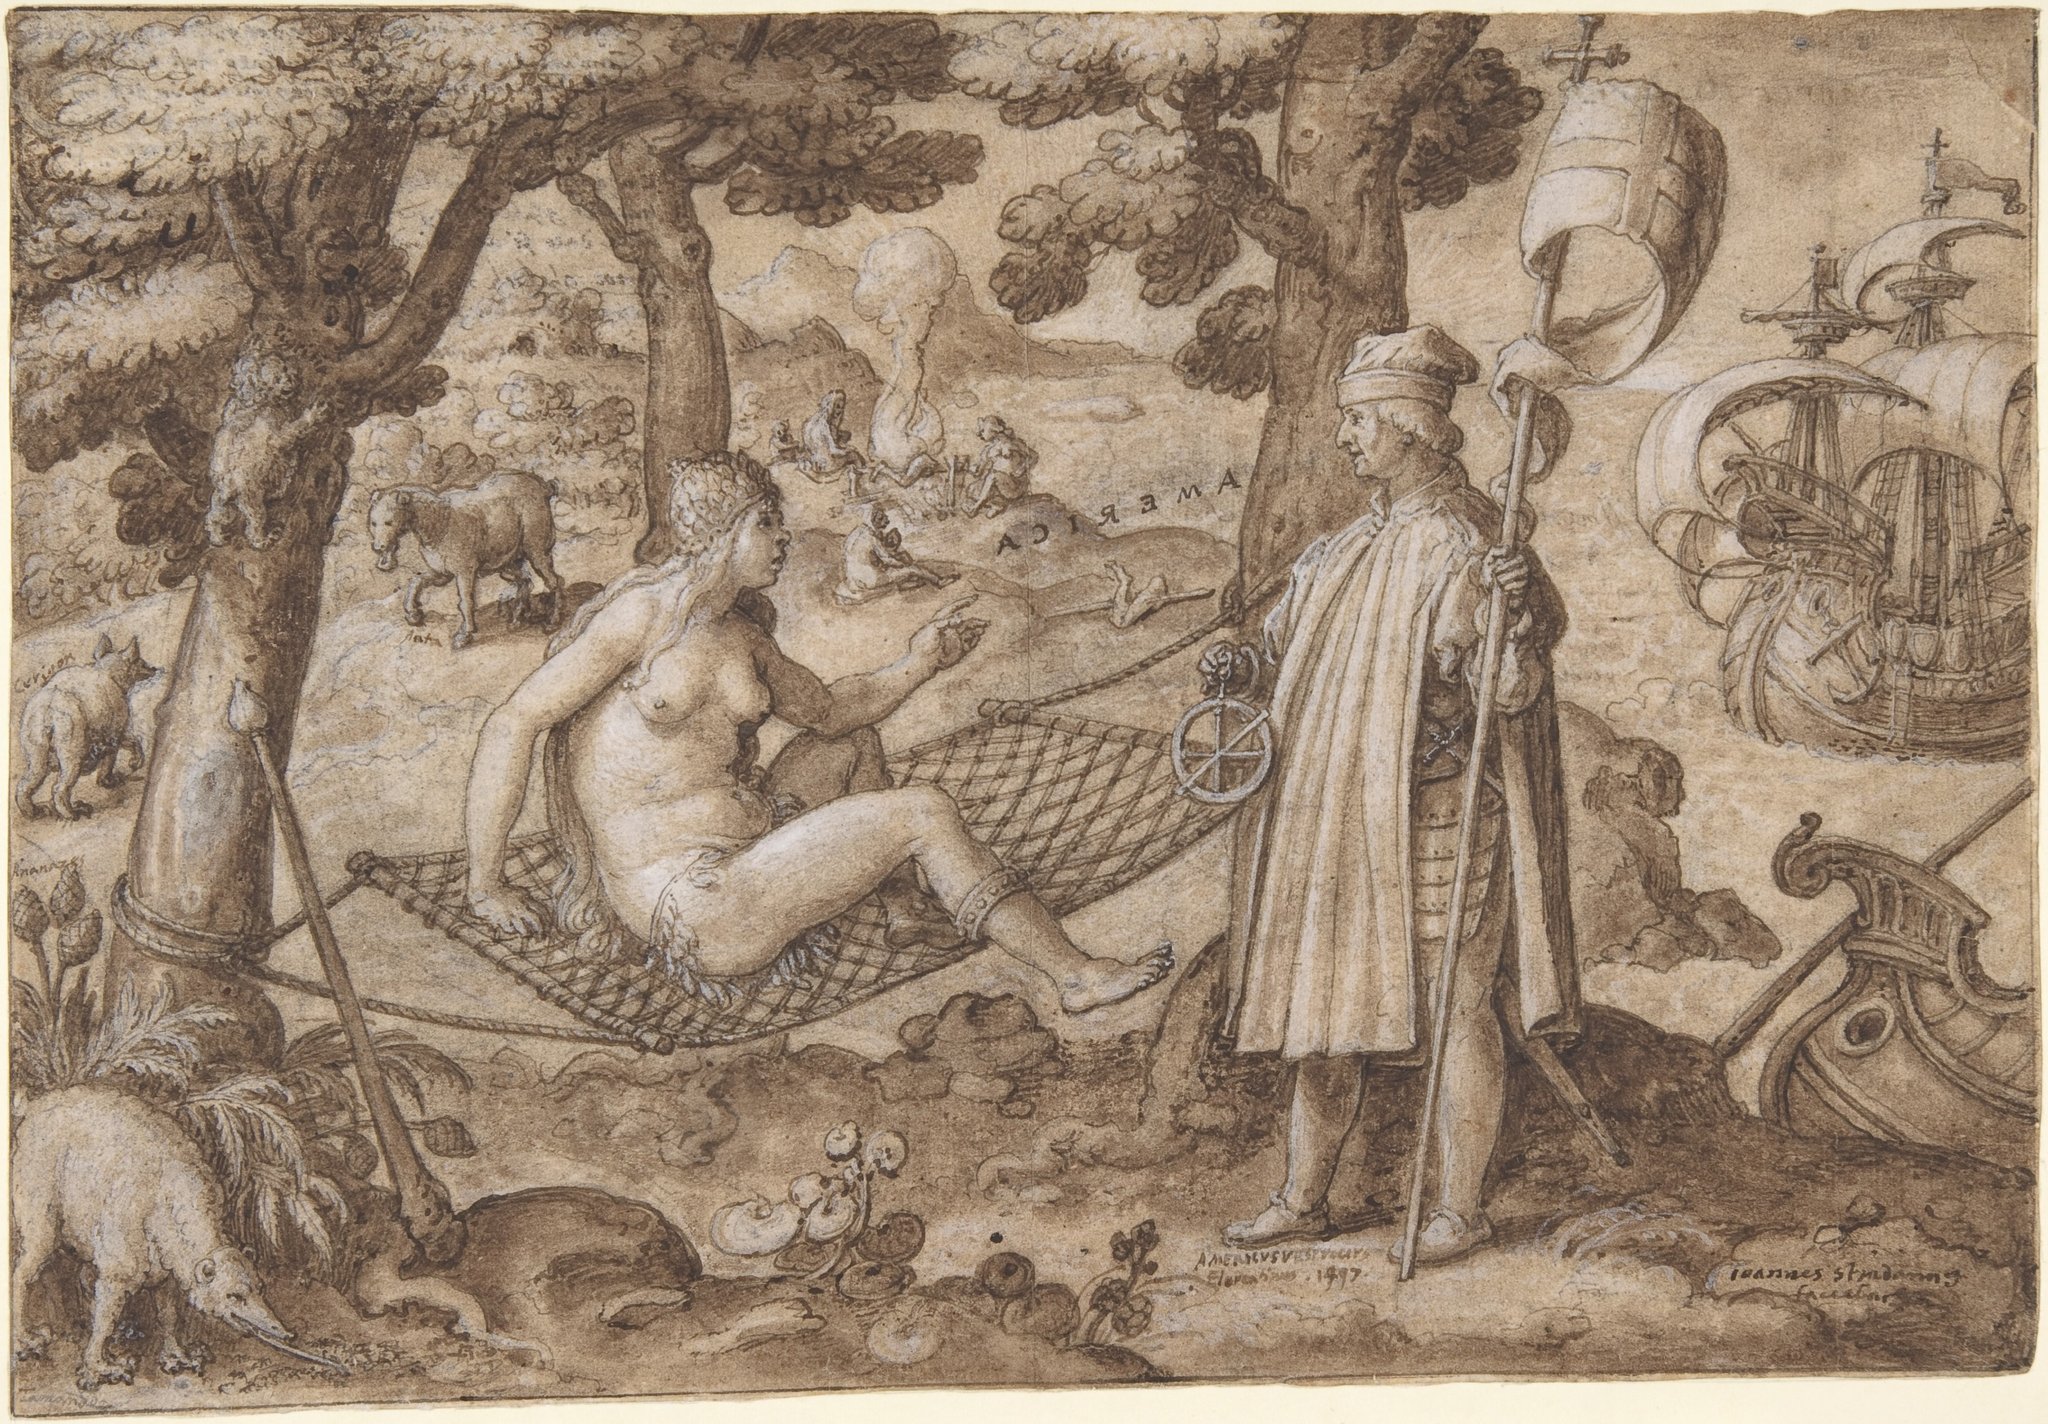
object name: drawing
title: Allegory of America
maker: jan van der straet, called stradanus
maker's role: artist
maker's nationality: netherlandish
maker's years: 1523-1605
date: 1587-1589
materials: chalk, ink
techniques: heightening, incising, pen, wash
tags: animals,men,female nudes,trees